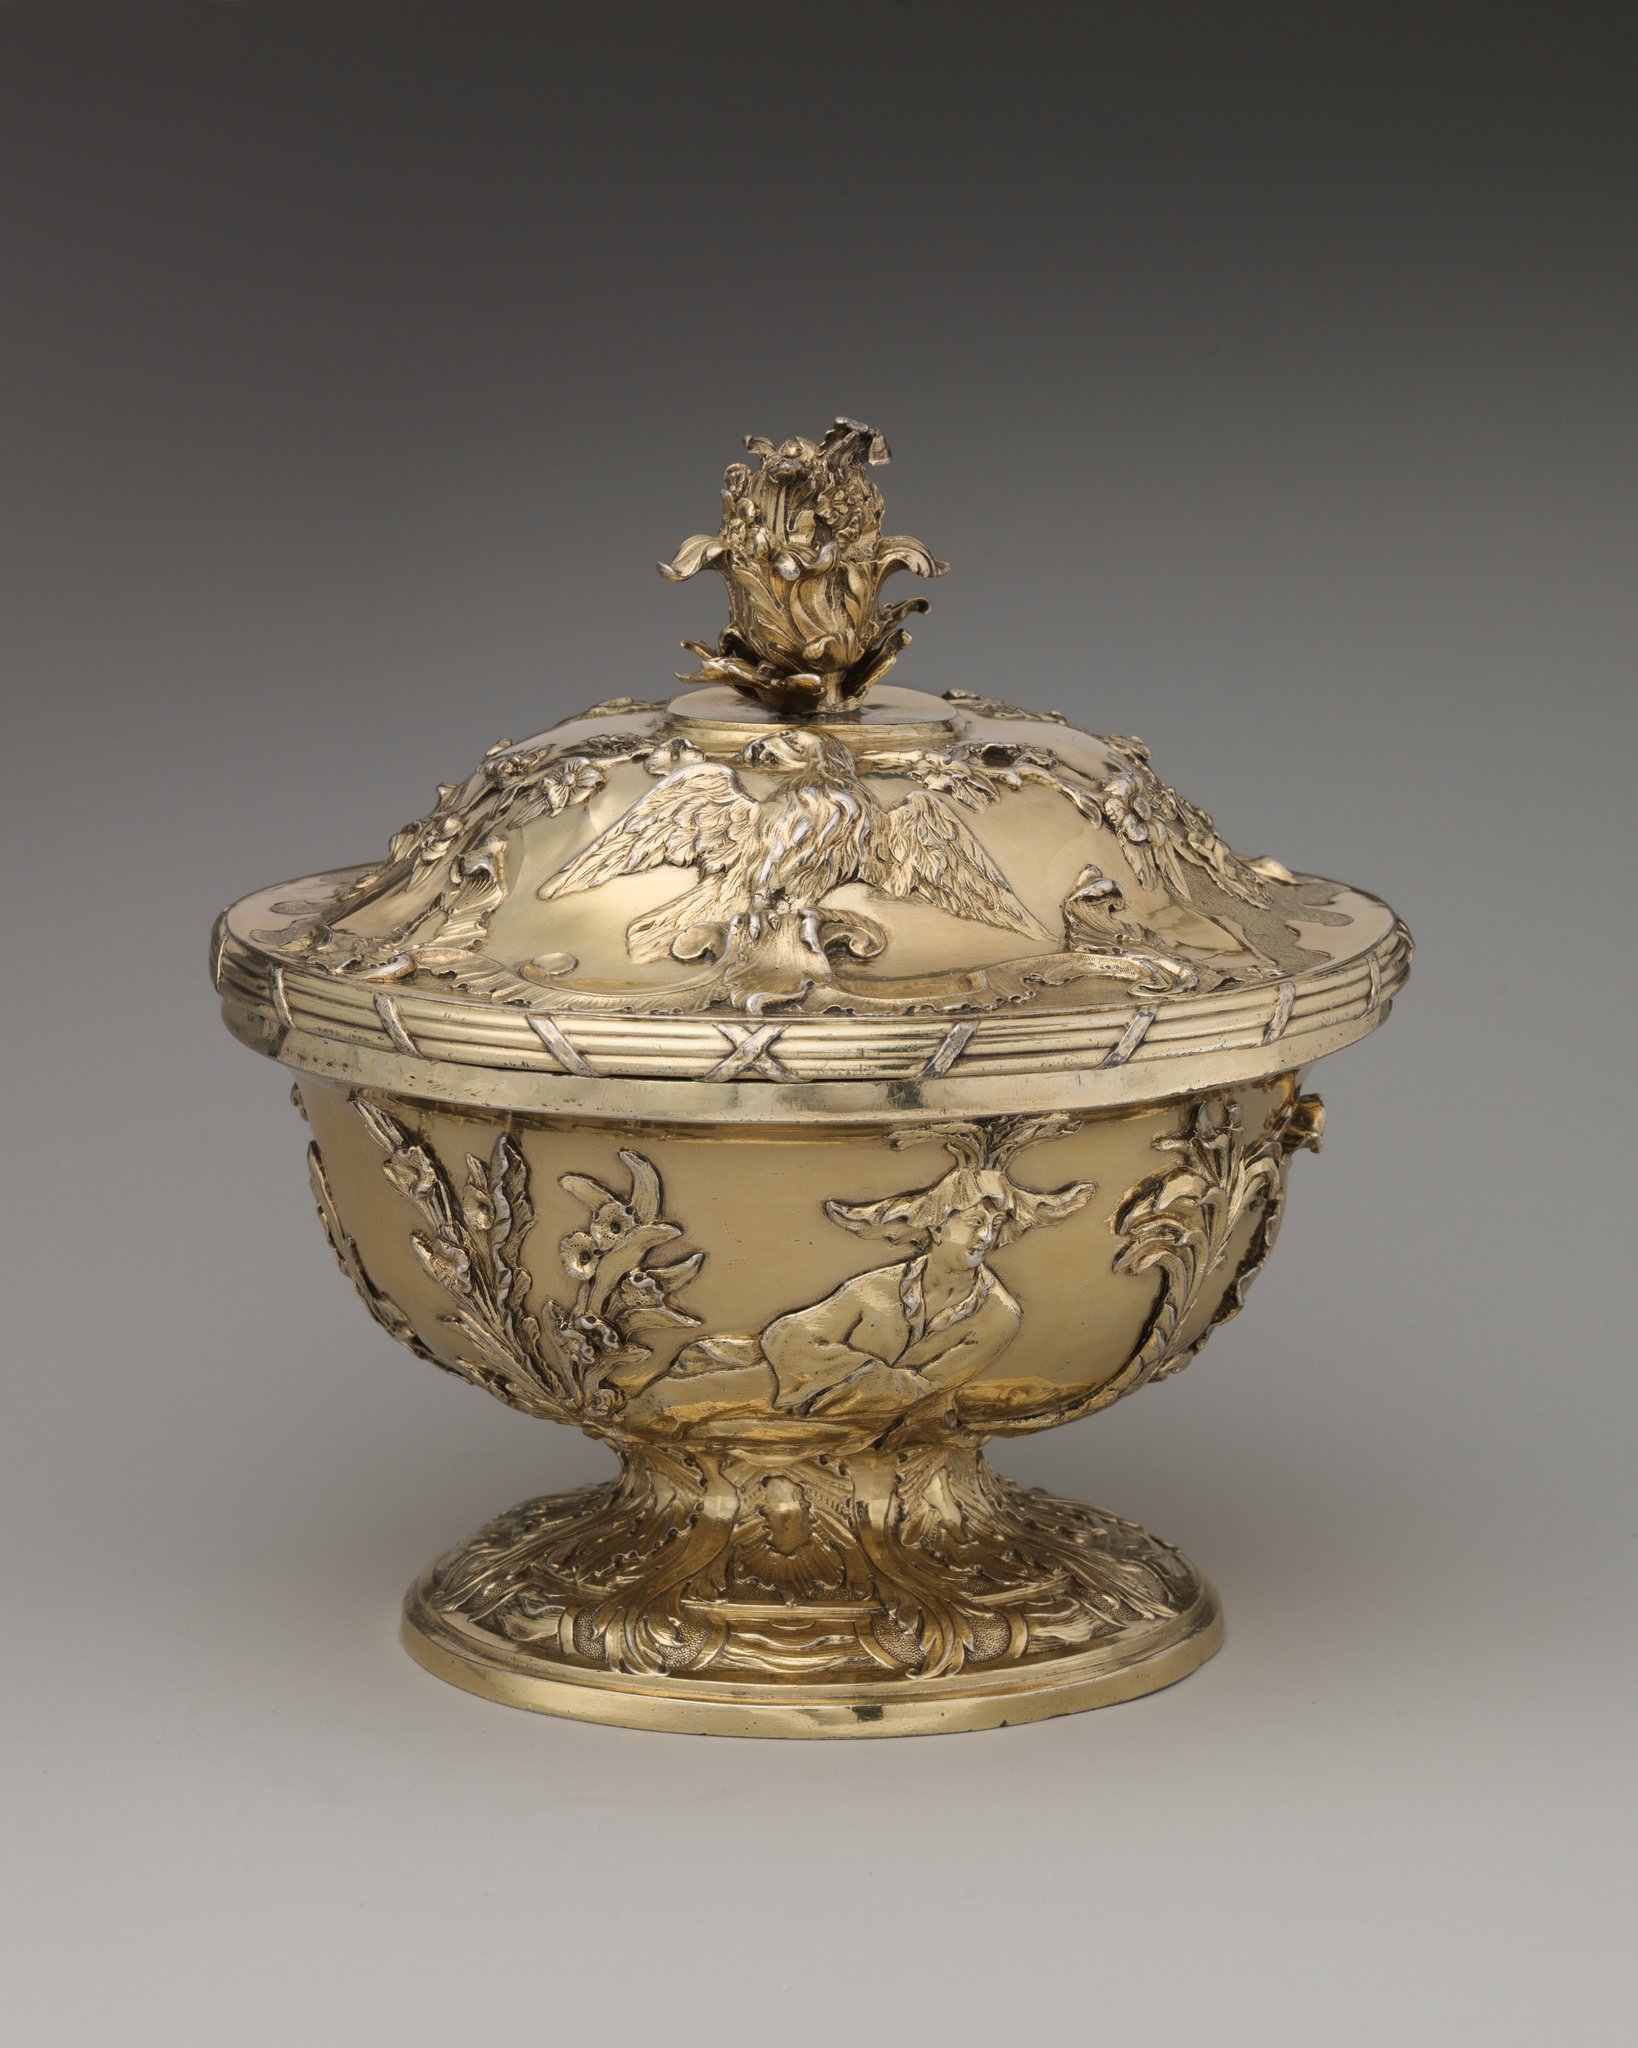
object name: covered bowl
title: Bowl with cover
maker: james shruder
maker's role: maker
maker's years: 1707-1749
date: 1737-1738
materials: silver gilt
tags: eagles,men,flowers